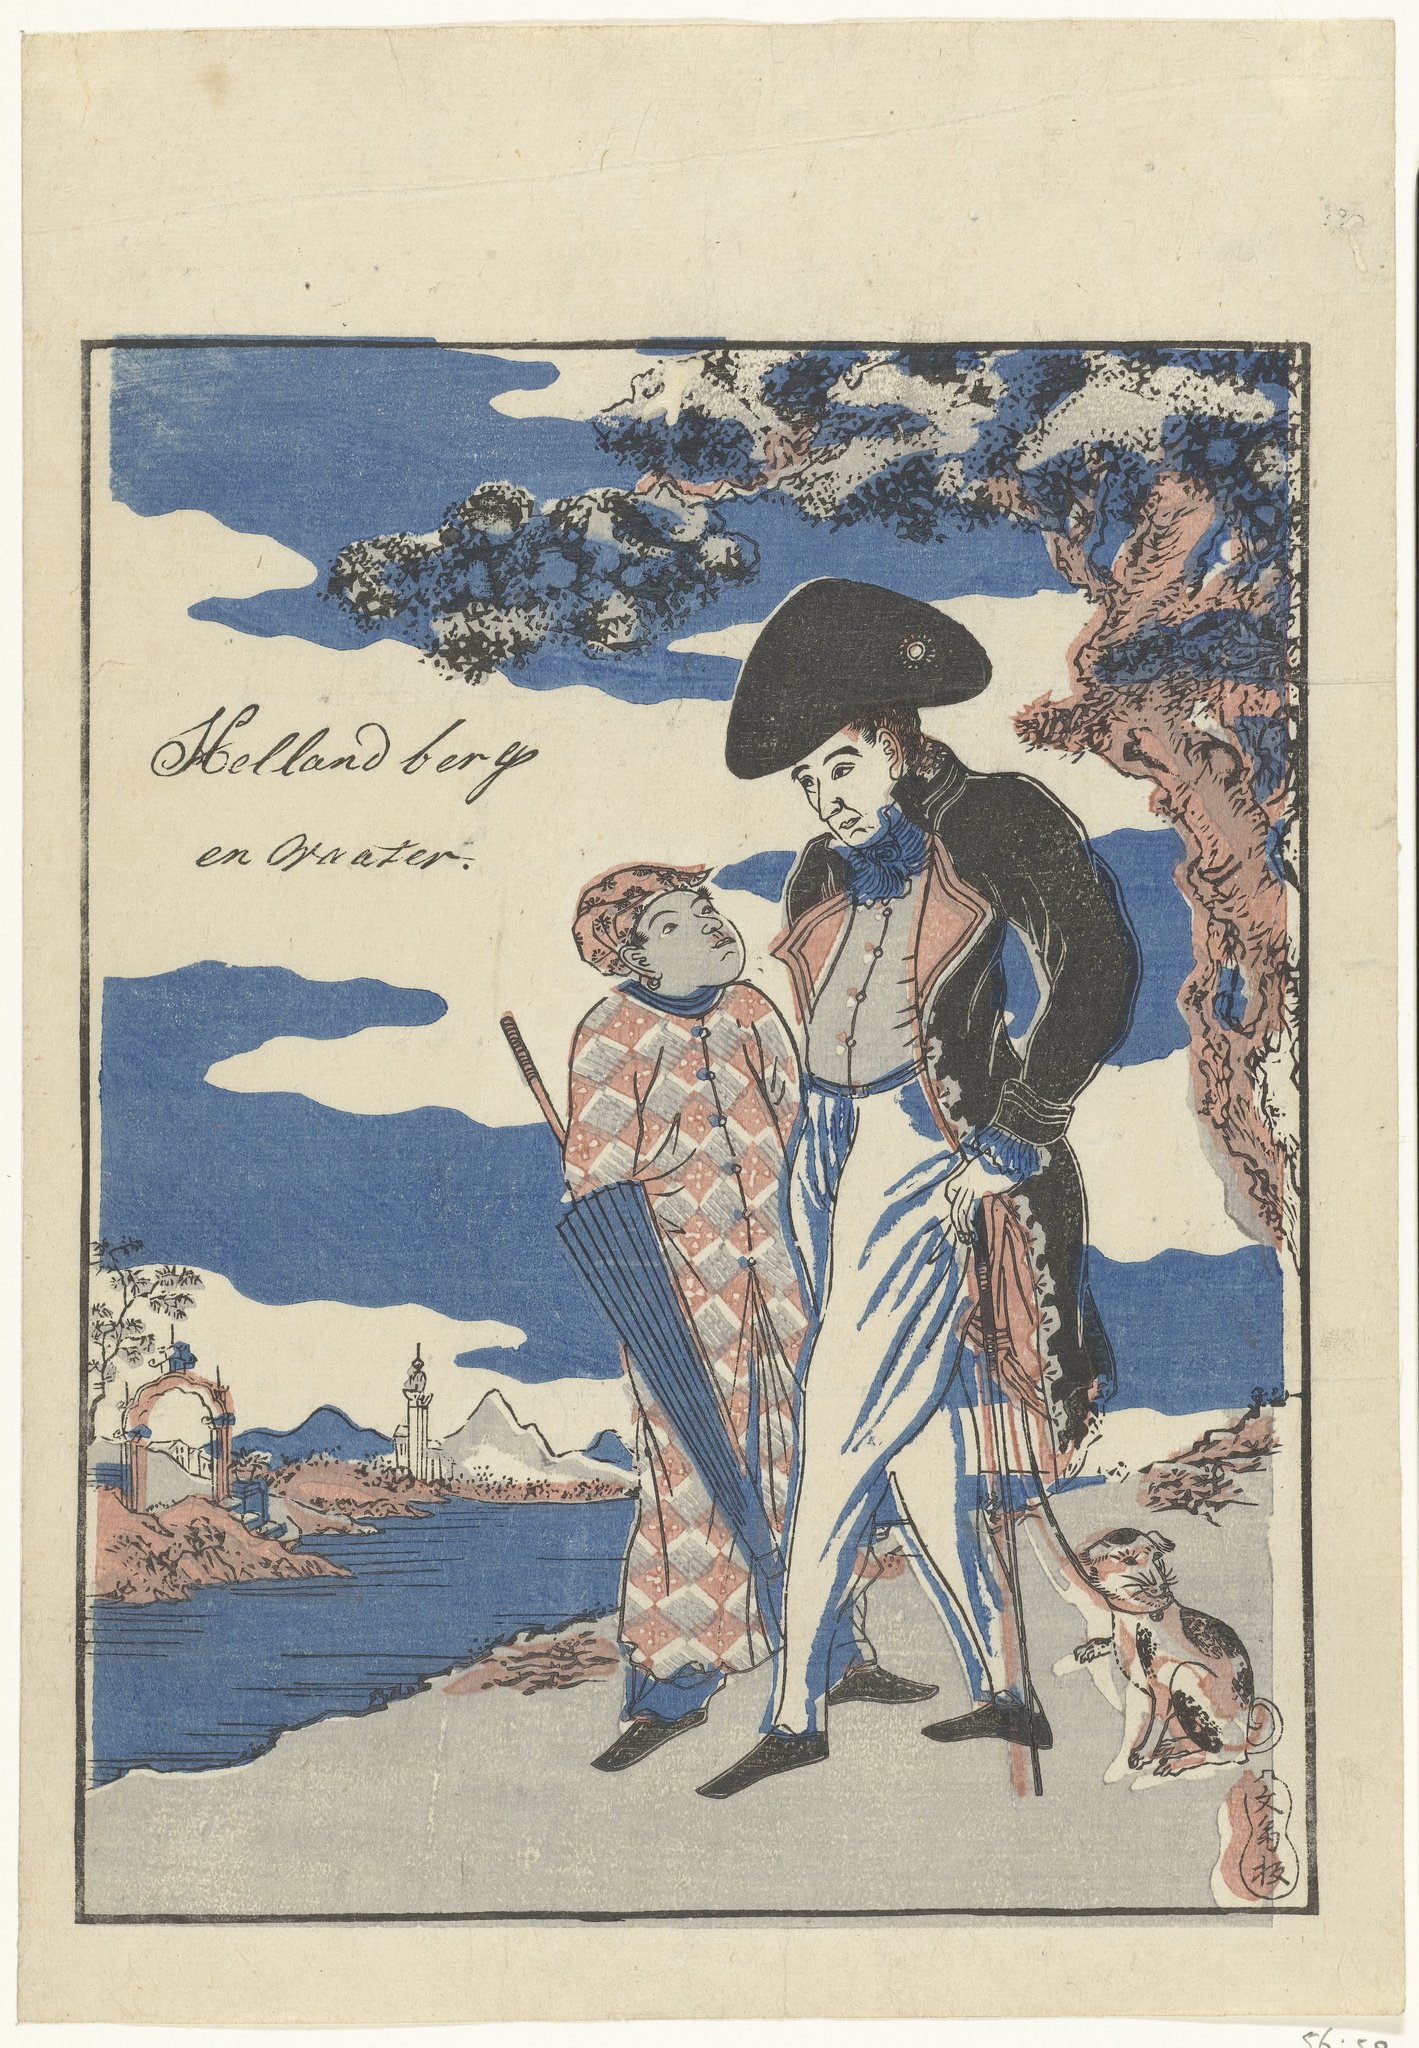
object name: print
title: Nederlands opperhoofd met Javaanse bediende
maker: Anonymous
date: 1800-1850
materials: paper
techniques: woodcut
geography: japan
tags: standing figure, landscapes (+ landscape with figures, staffage), house personnel, servants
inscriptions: collector's mark: Lugt 2228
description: Nederlander met hond, staand naast bediende met parasol, in westers landschap; 'berg en landschap' zoals vermeld op de prent is een letterlijke vertaling van het Japanse woord voor 'landschap': sansui. (Nagasaki-e)